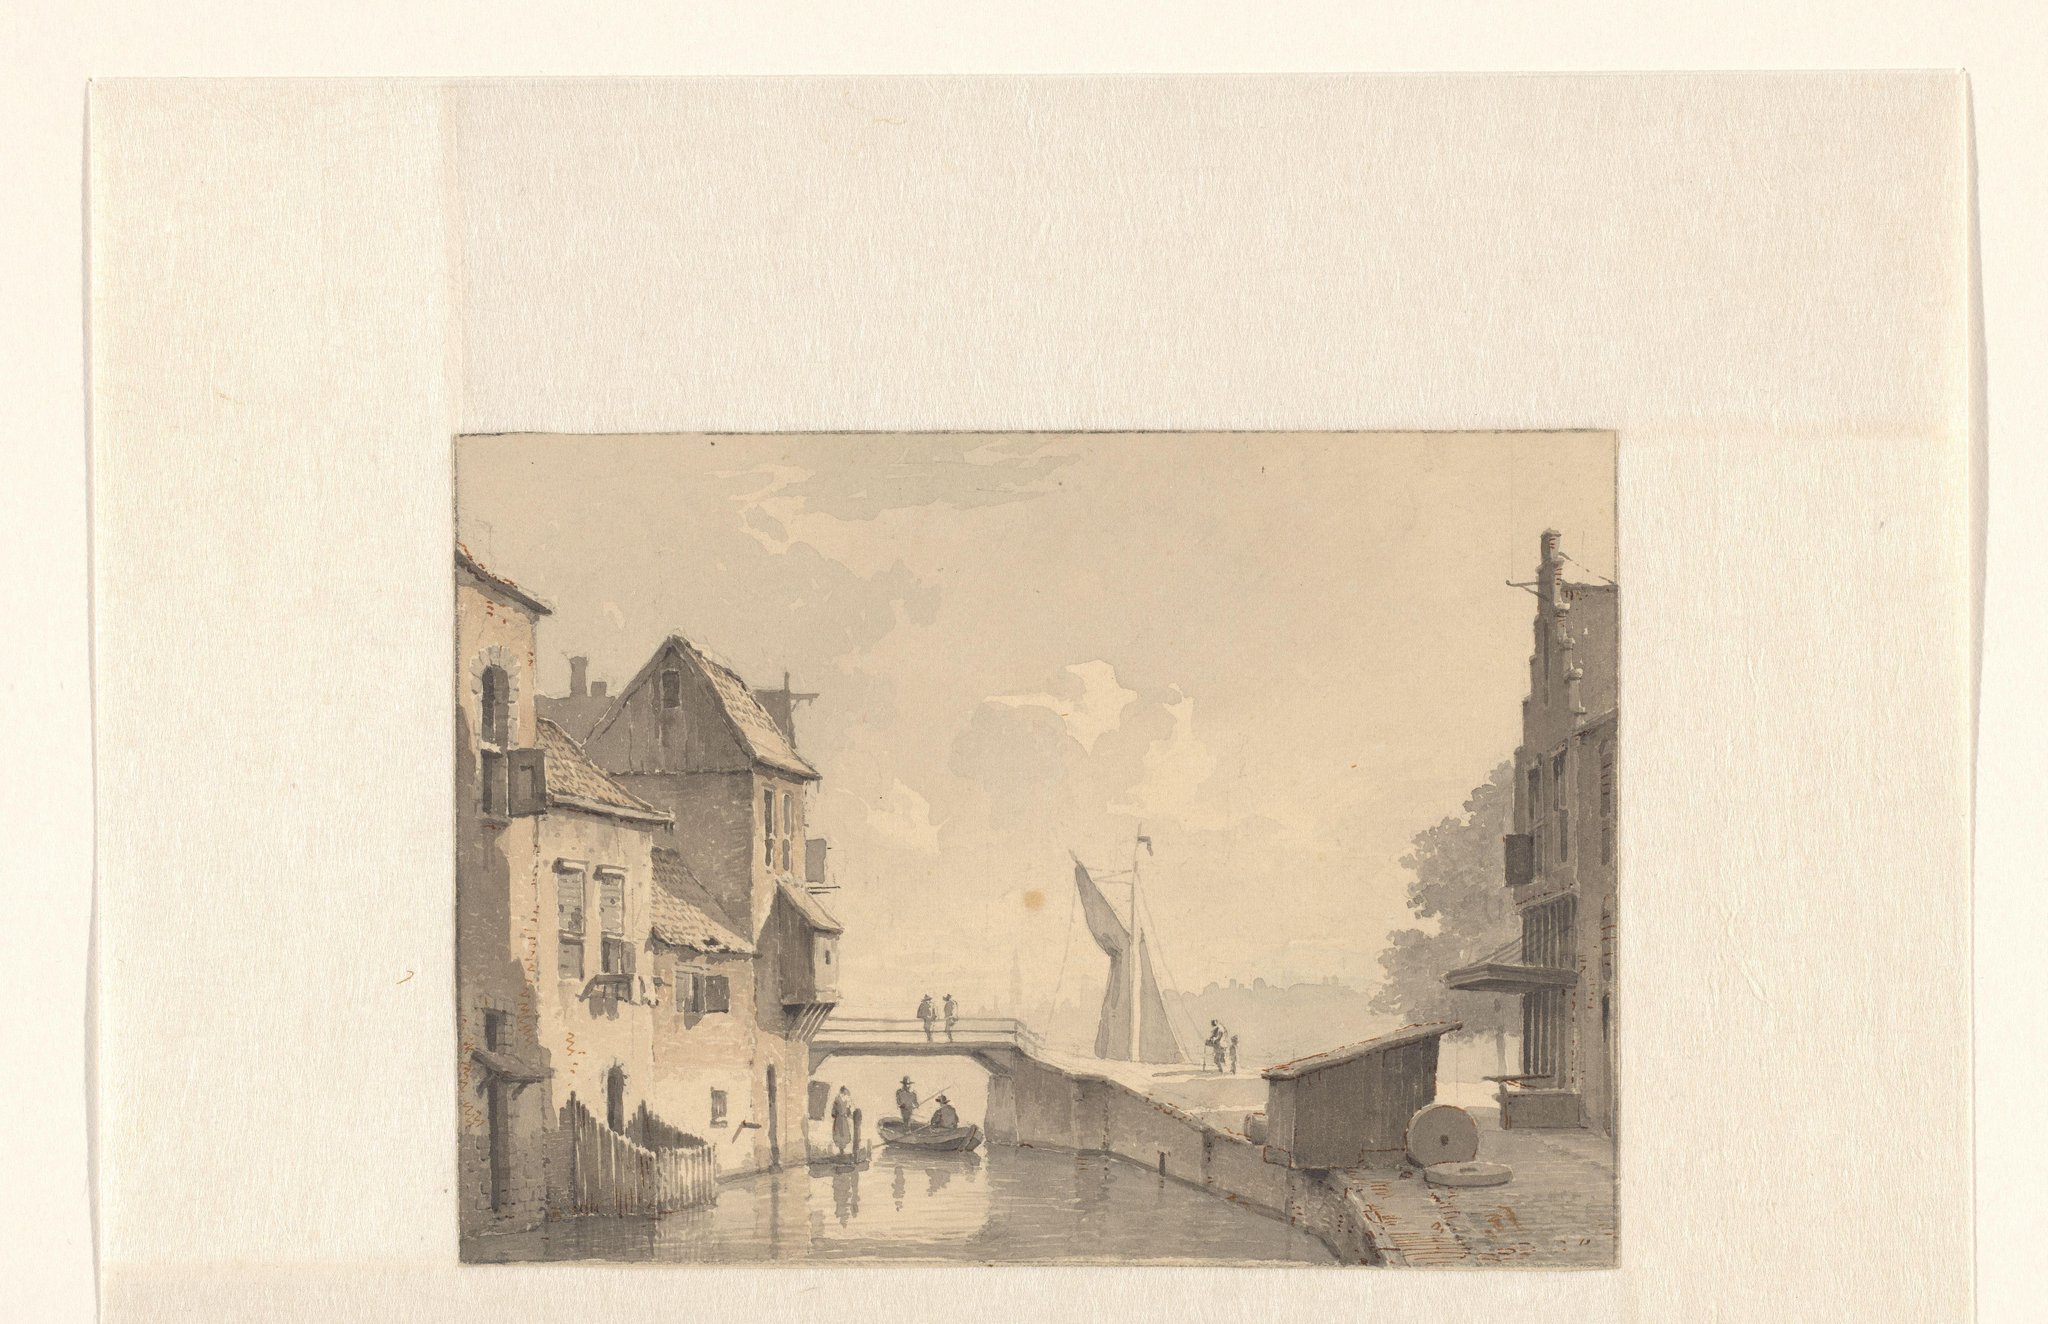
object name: drawing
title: Gezicht op een gracht in een stad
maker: kasparus karsen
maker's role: draughtsman, painter, print maker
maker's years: 1810-1896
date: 1820-1896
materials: ink, paper, pencil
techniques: brush, pen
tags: canals, waters (in city)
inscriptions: collector's mark: Lugt 2228, inscription: ‘Aan Ed. Karsen/ geschenk van Cil[...]arm (Maart 1830)/ 9 Mei 1930’, name: ‘K Karssen’